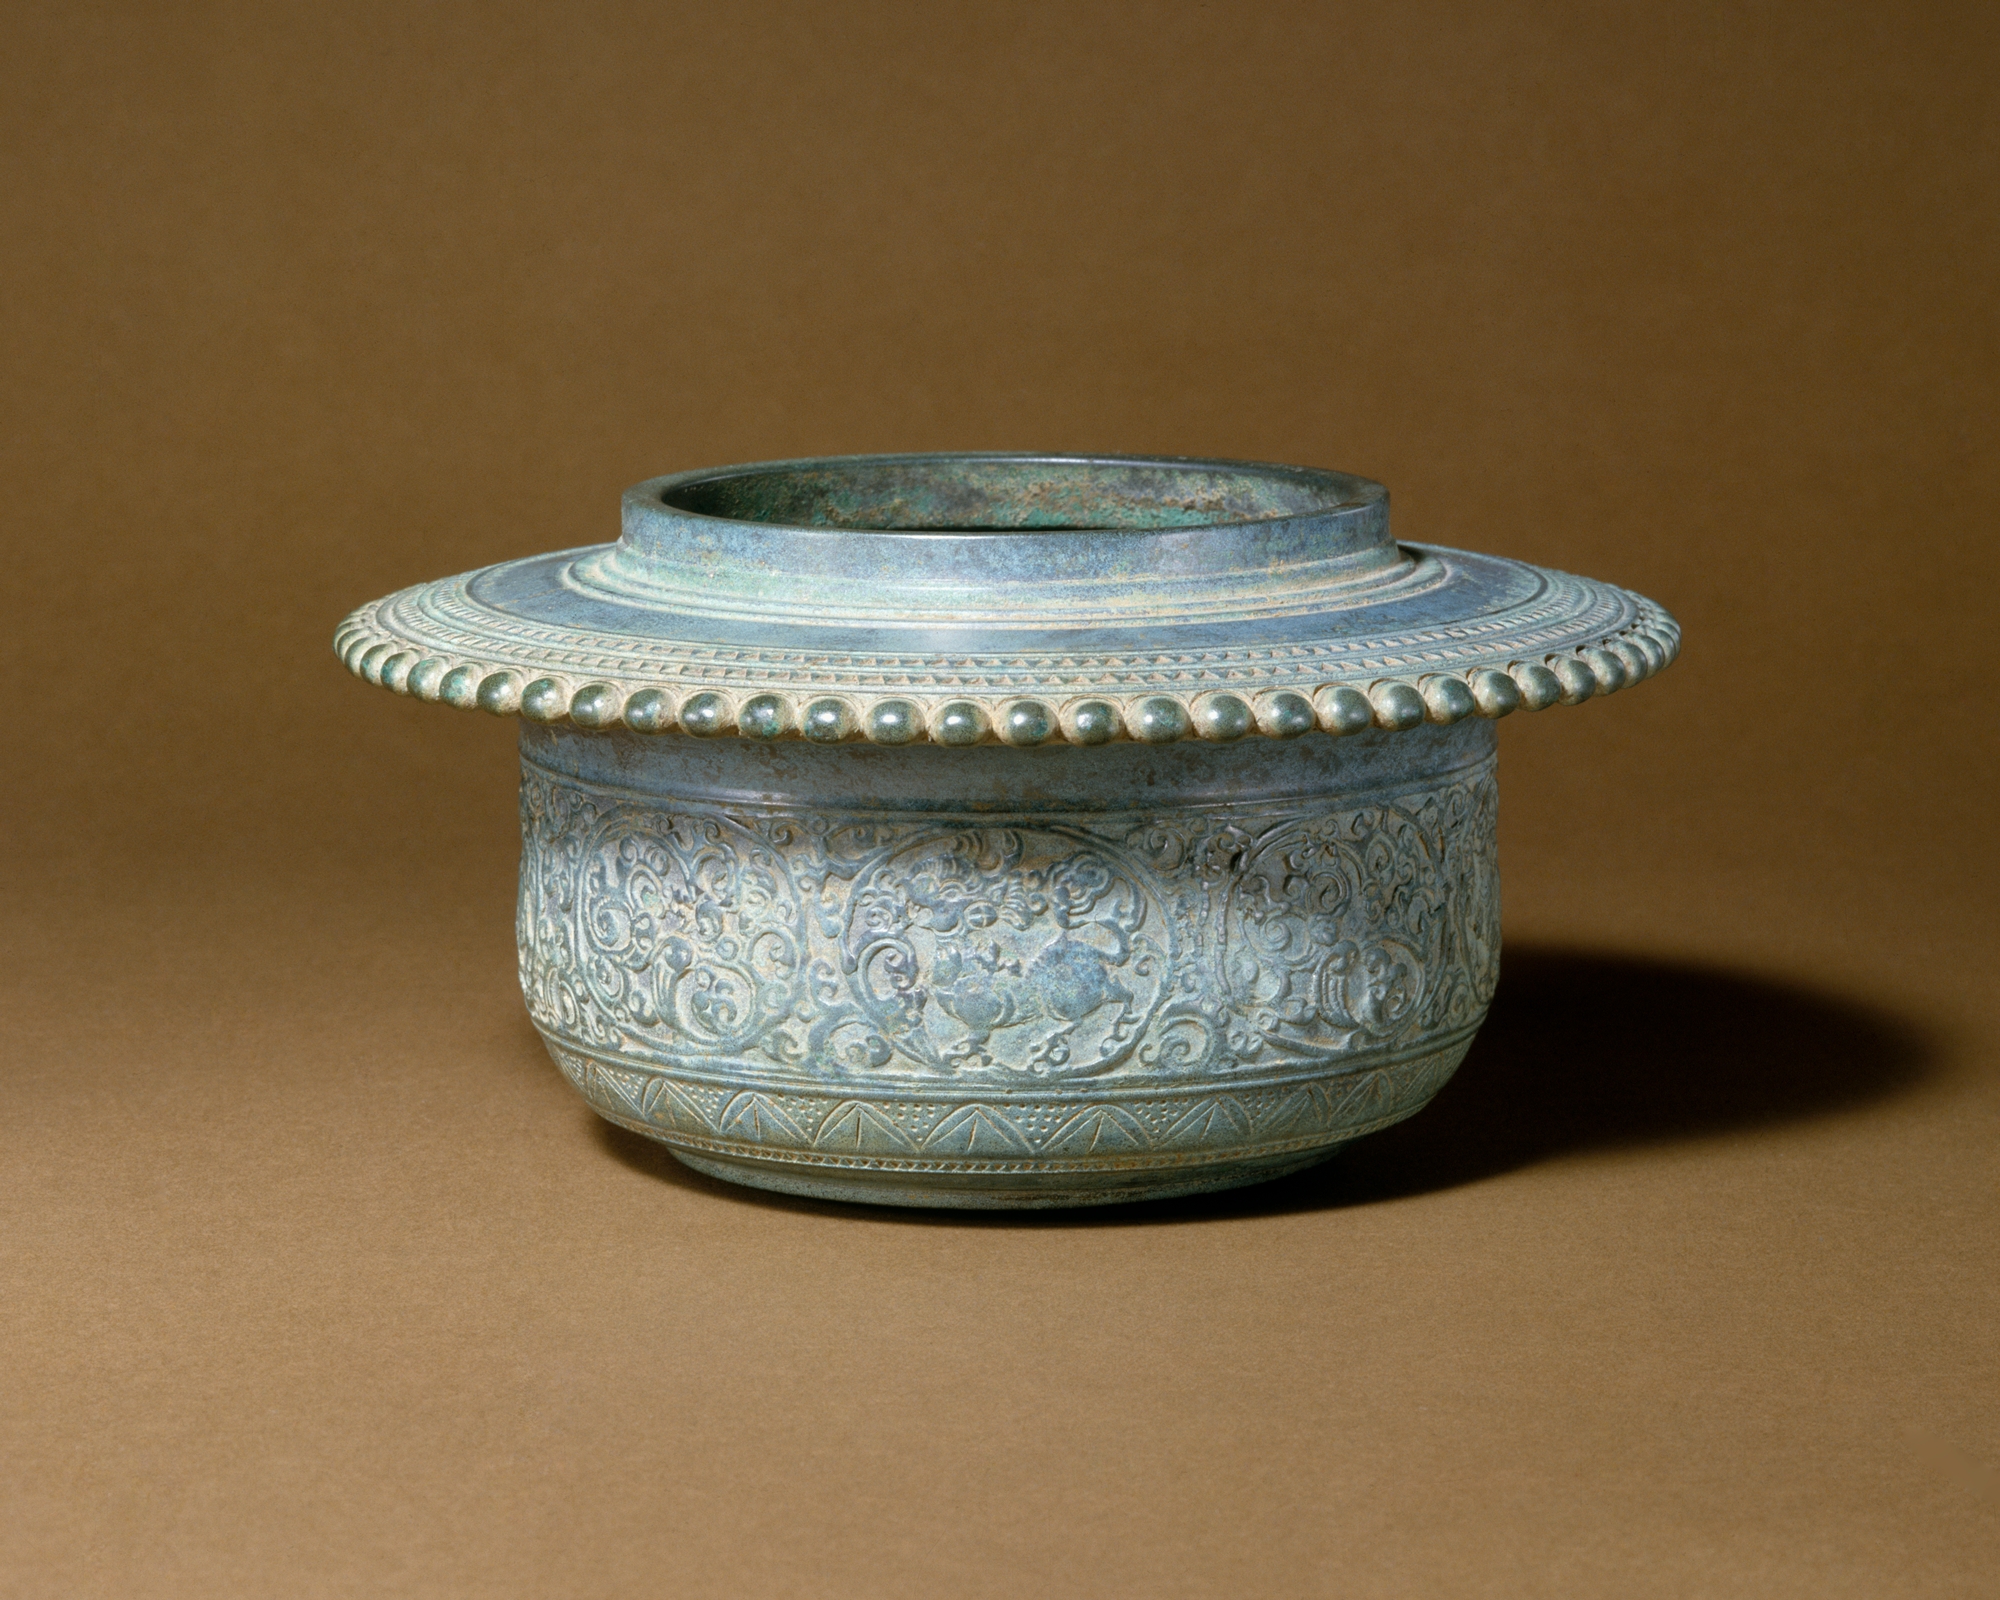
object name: holy water vessel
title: Holy-Water Vessel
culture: indonesian, javanese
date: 1001-1200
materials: bronze